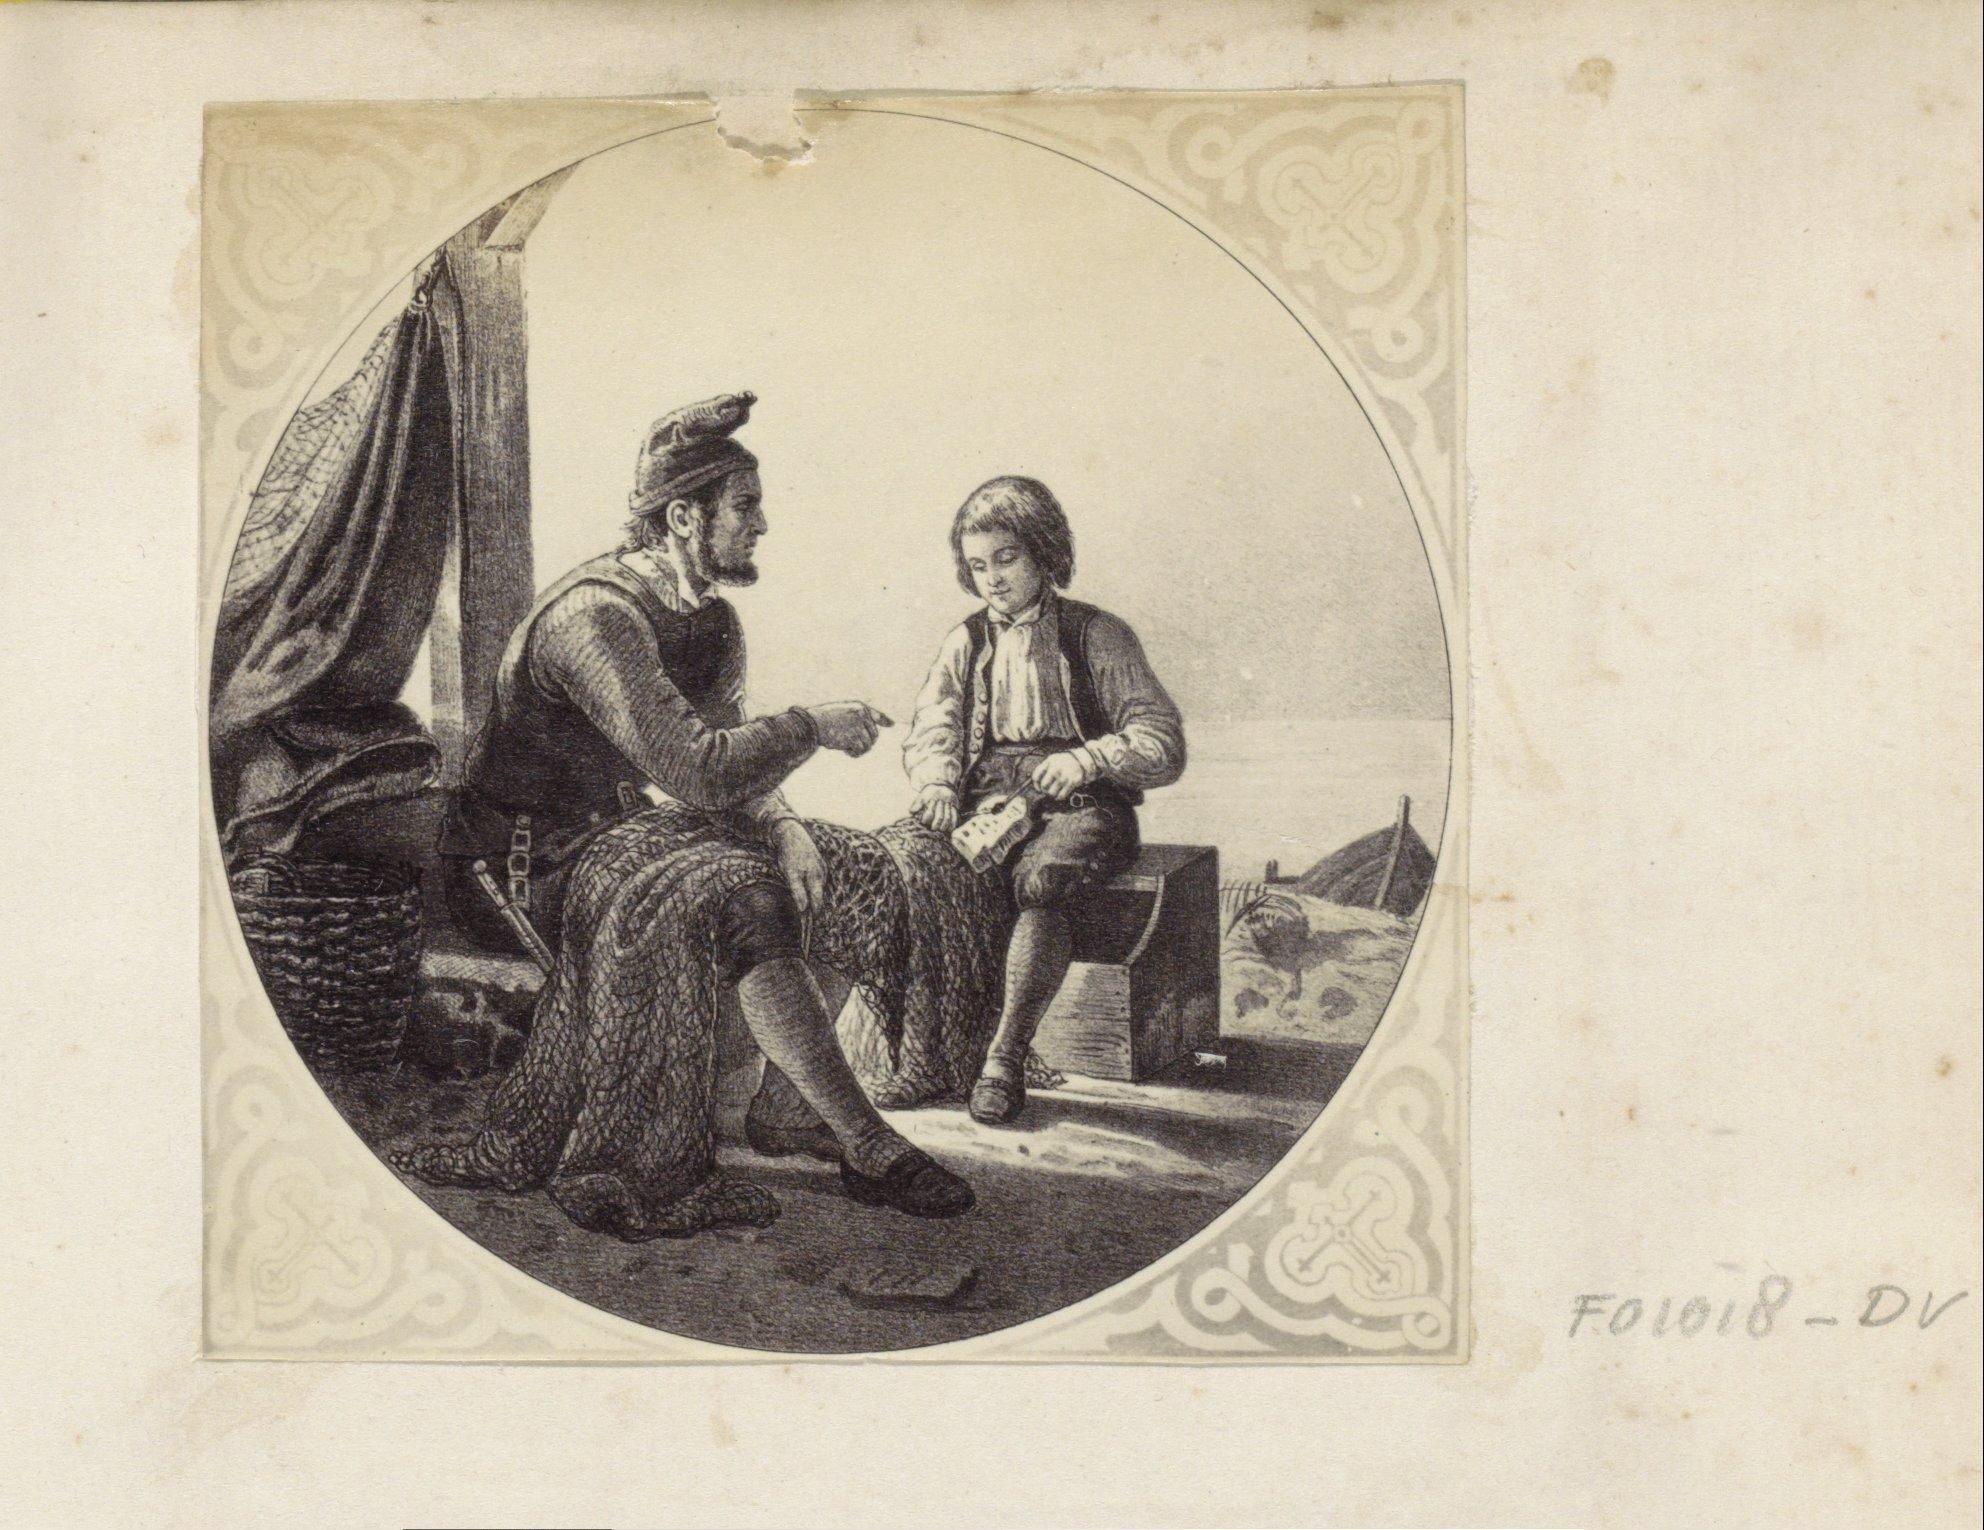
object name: reproduction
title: Fotoreproductie van (vermoedelijk) een prent naar een schilderij van Adolph Tidemand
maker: Anonymous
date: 1860-1870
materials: paper, photographic support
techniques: albumen print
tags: father and son(s) (family group), fisherman, mending of fishing nets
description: Onderdeel van Engels familiealbum met foto's van personen, reizen, cricket en kunstwerken.